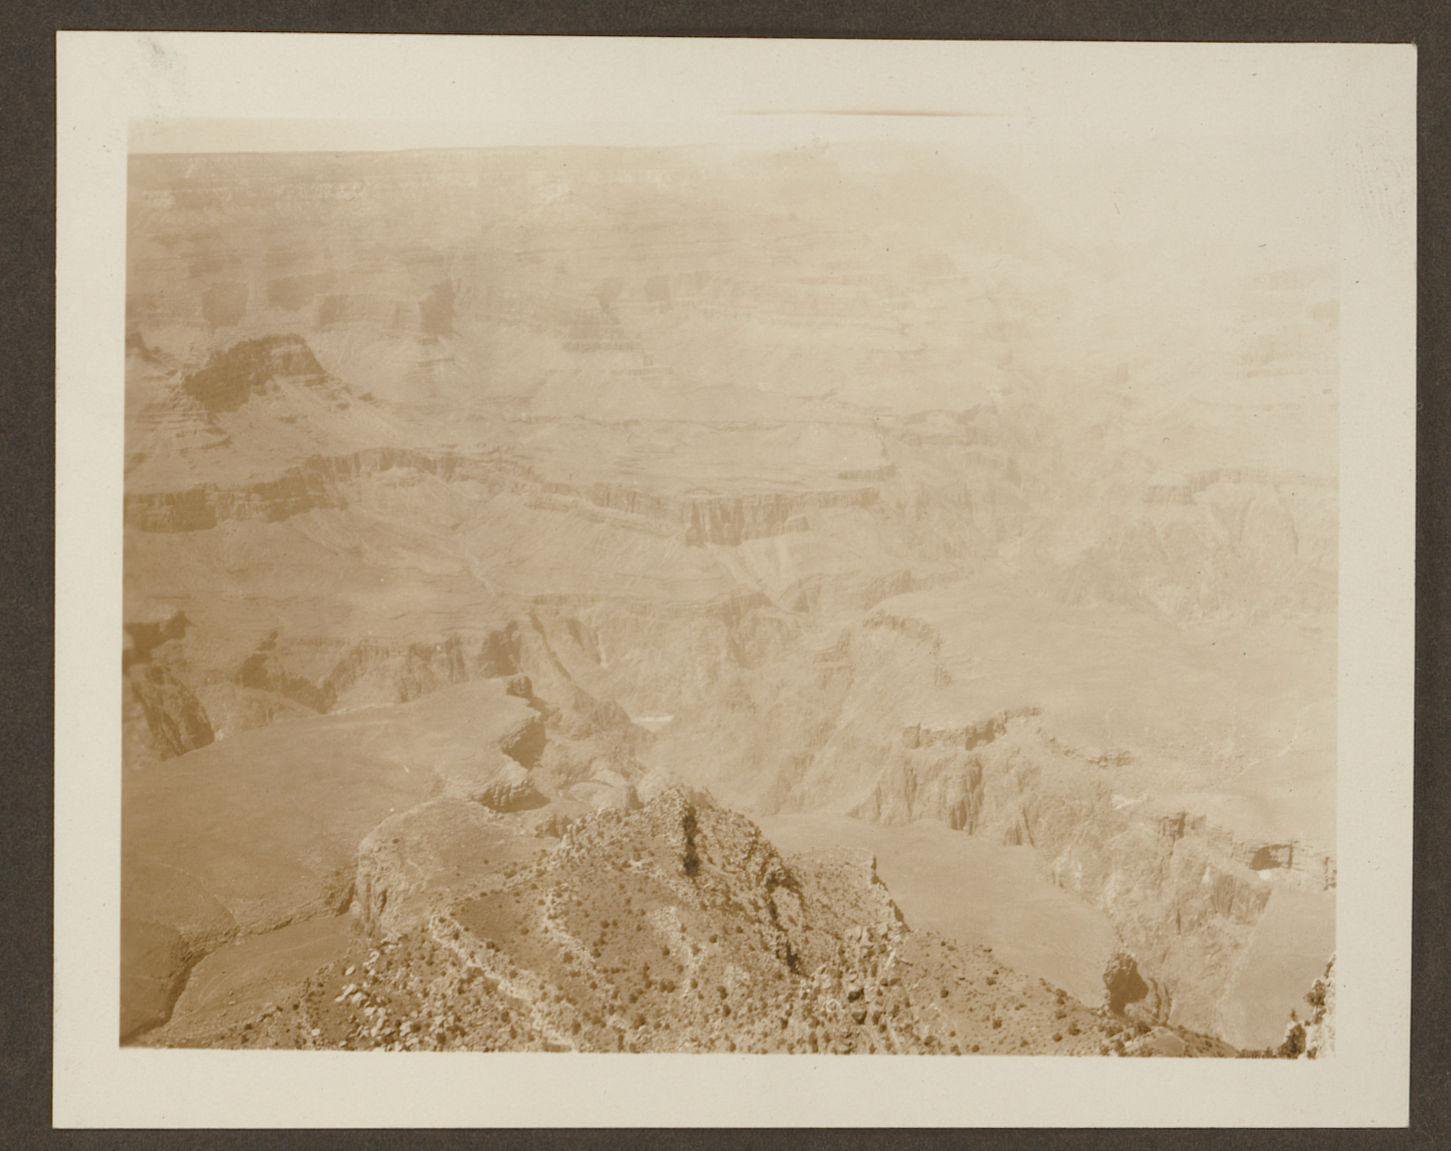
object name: photograph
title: Gezicht op de Grand Canyon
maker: Anonymous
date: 1928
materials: photographic support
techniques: gelatin silver print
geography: grand canyon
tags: ravine, chasm, abyss, canyon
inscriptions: annotation: ‘Grand Canyon’